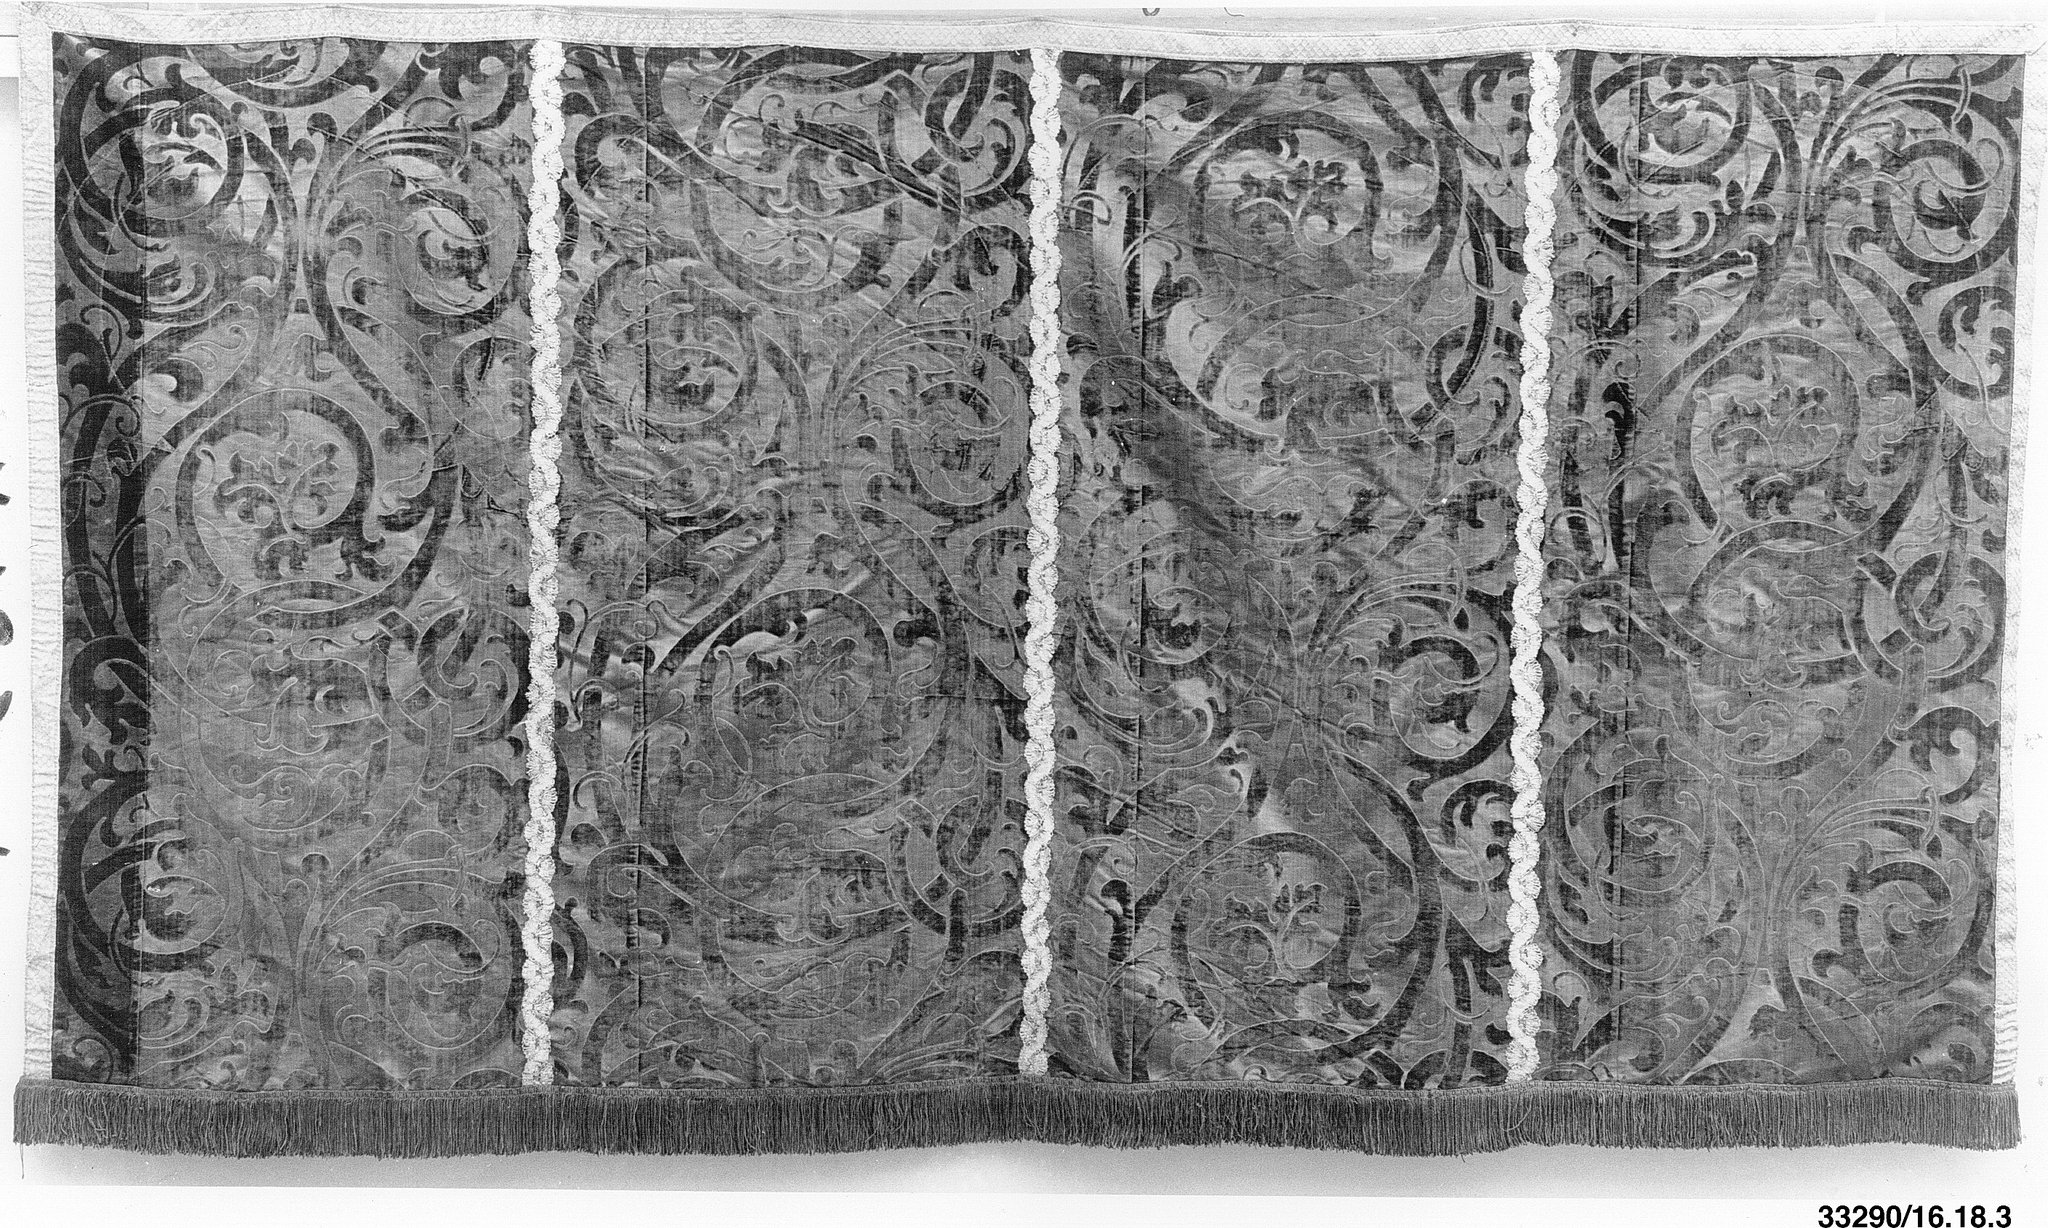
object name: hanging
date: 1850-1900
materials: silk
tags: leaves